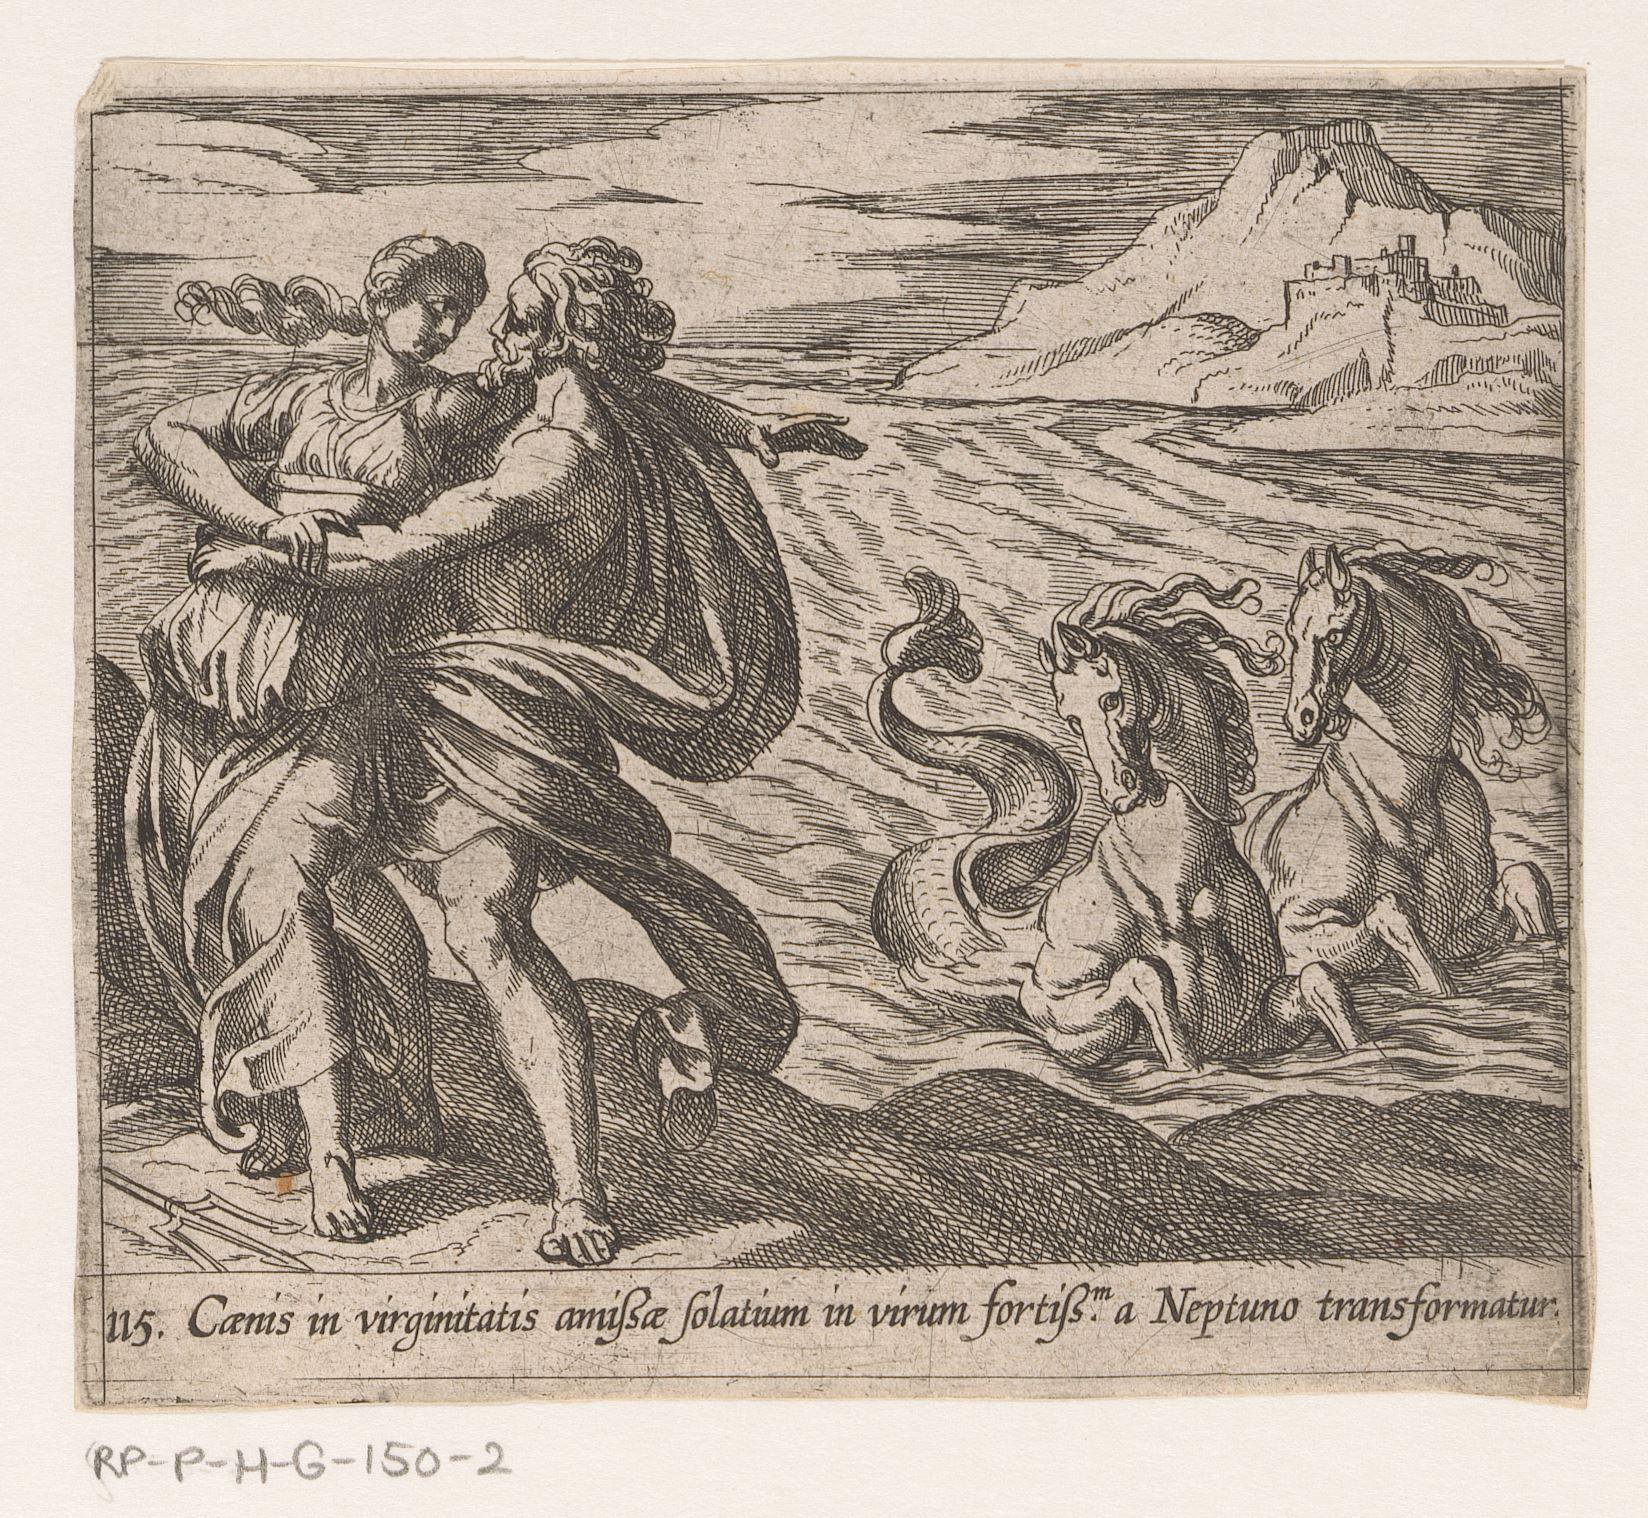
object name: print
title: De verkrachting van Caenis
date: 1606-1638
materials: paper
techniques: etching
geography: amsterdam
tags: neptune ravishes caenis, transgender, transsexual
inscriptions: collector's mark: ‘Hinloopen’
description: Deze prent maakt deel uit van een reeks van 150 prenten (+ titelprent) met voorstellingen van de Metamorfosen van Ovidius.